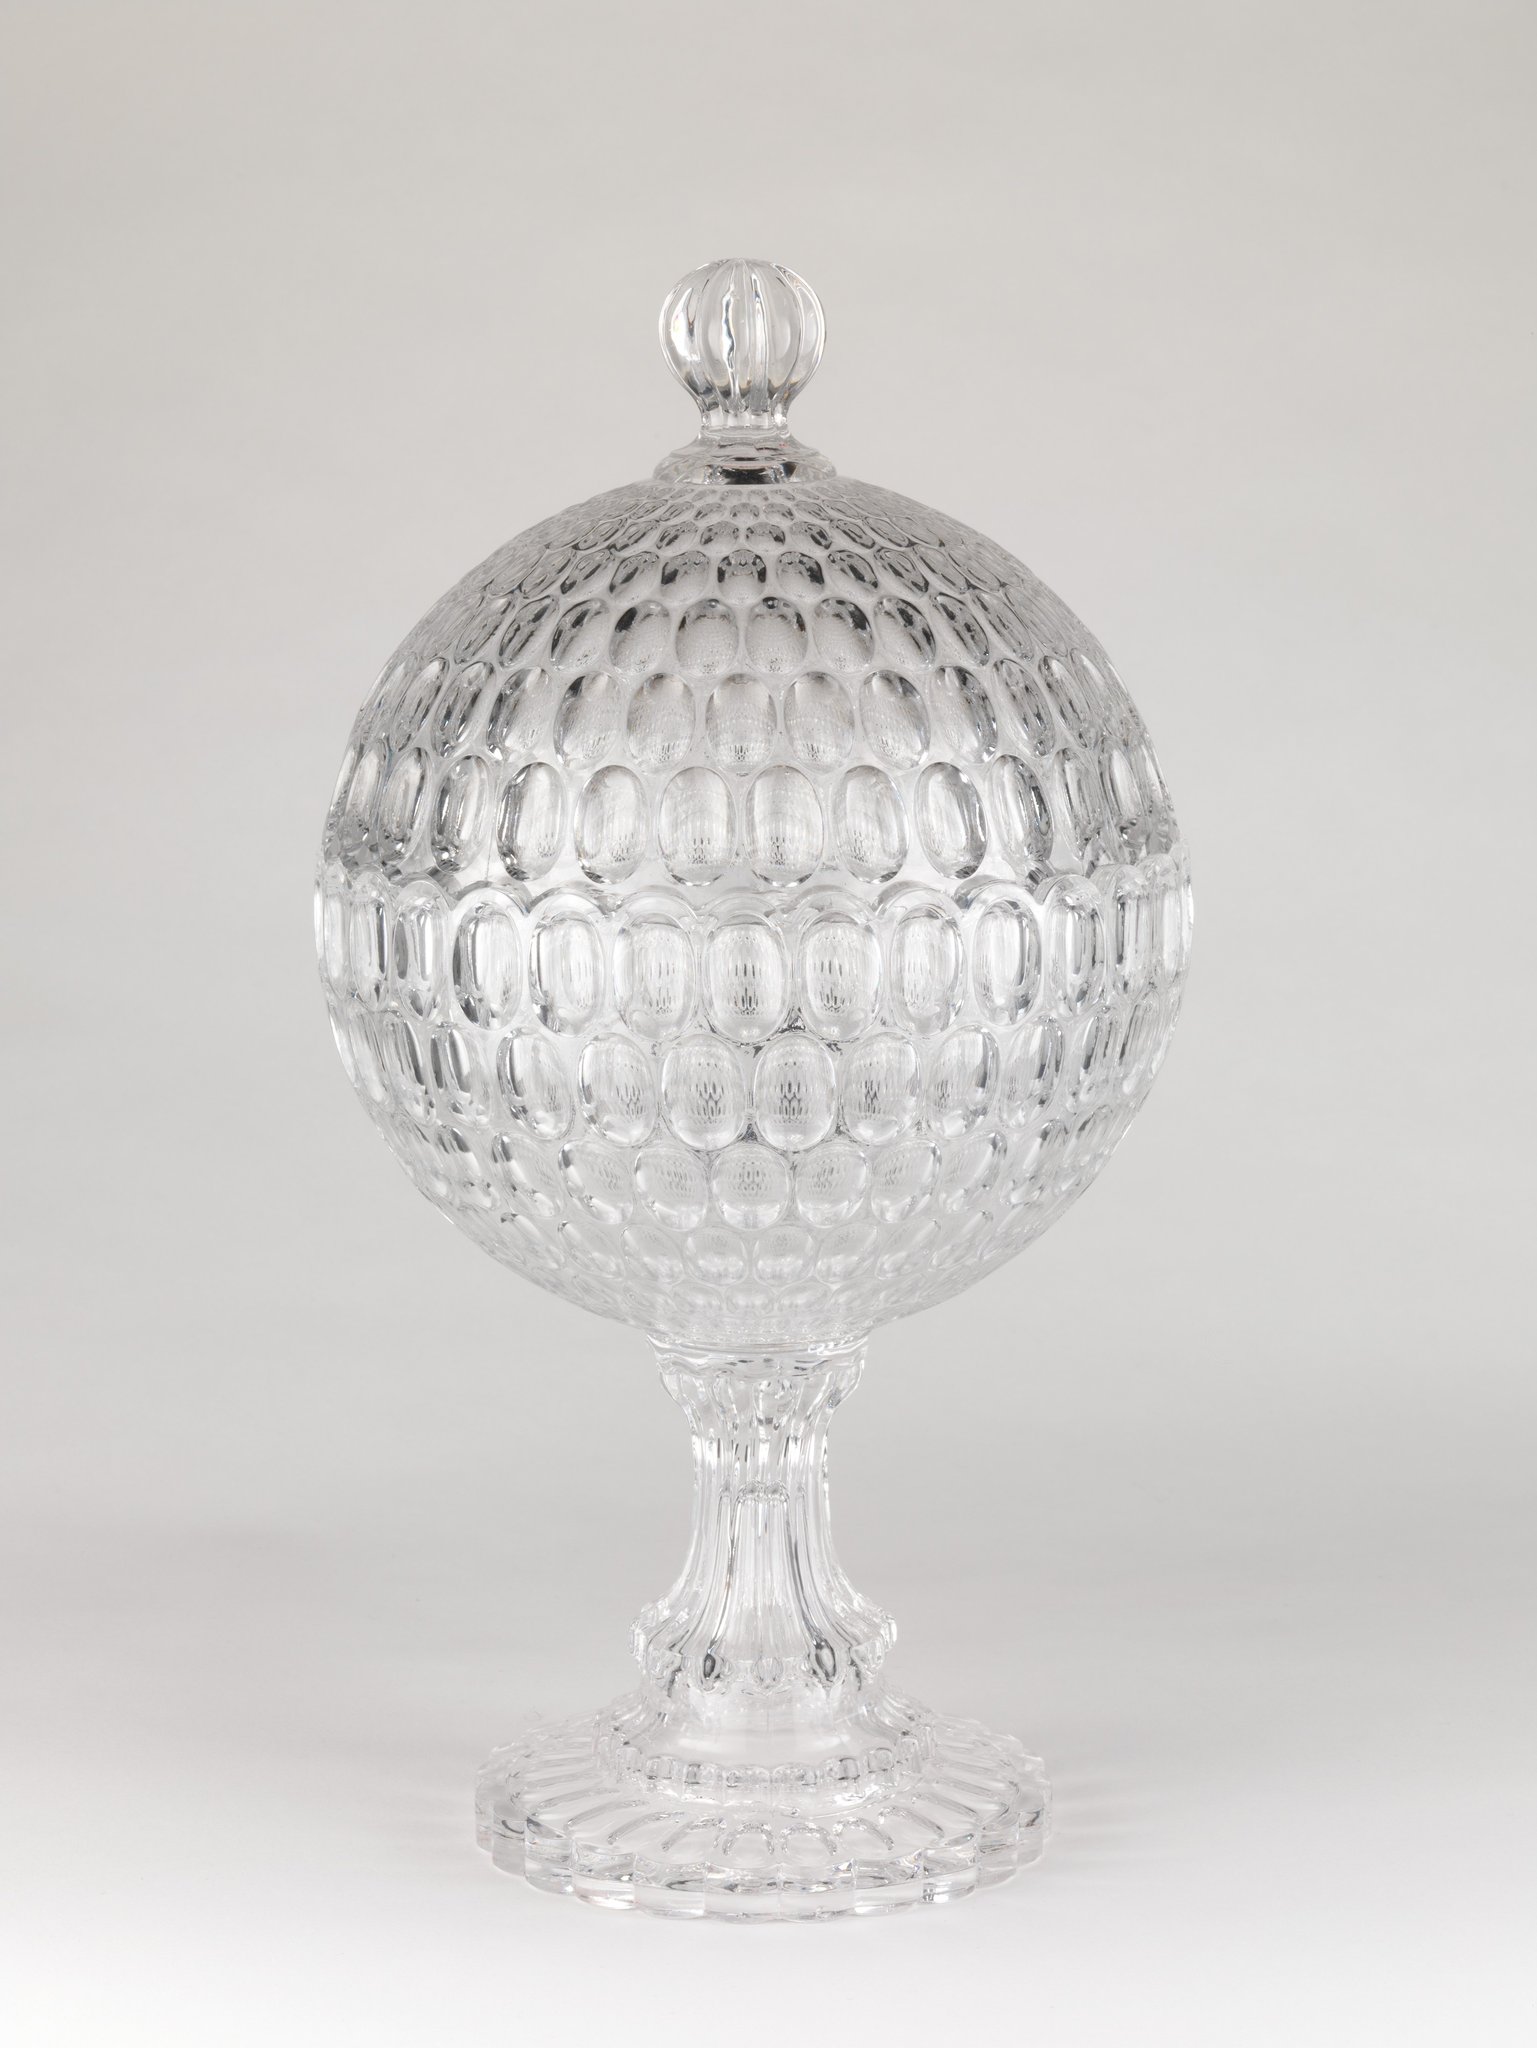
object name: compote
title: Covered compote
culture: american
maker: bakewell, pears and company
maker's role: maker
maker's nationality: american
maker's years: 1836-1882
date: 1850-1870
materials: glass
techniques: pressed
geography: united states